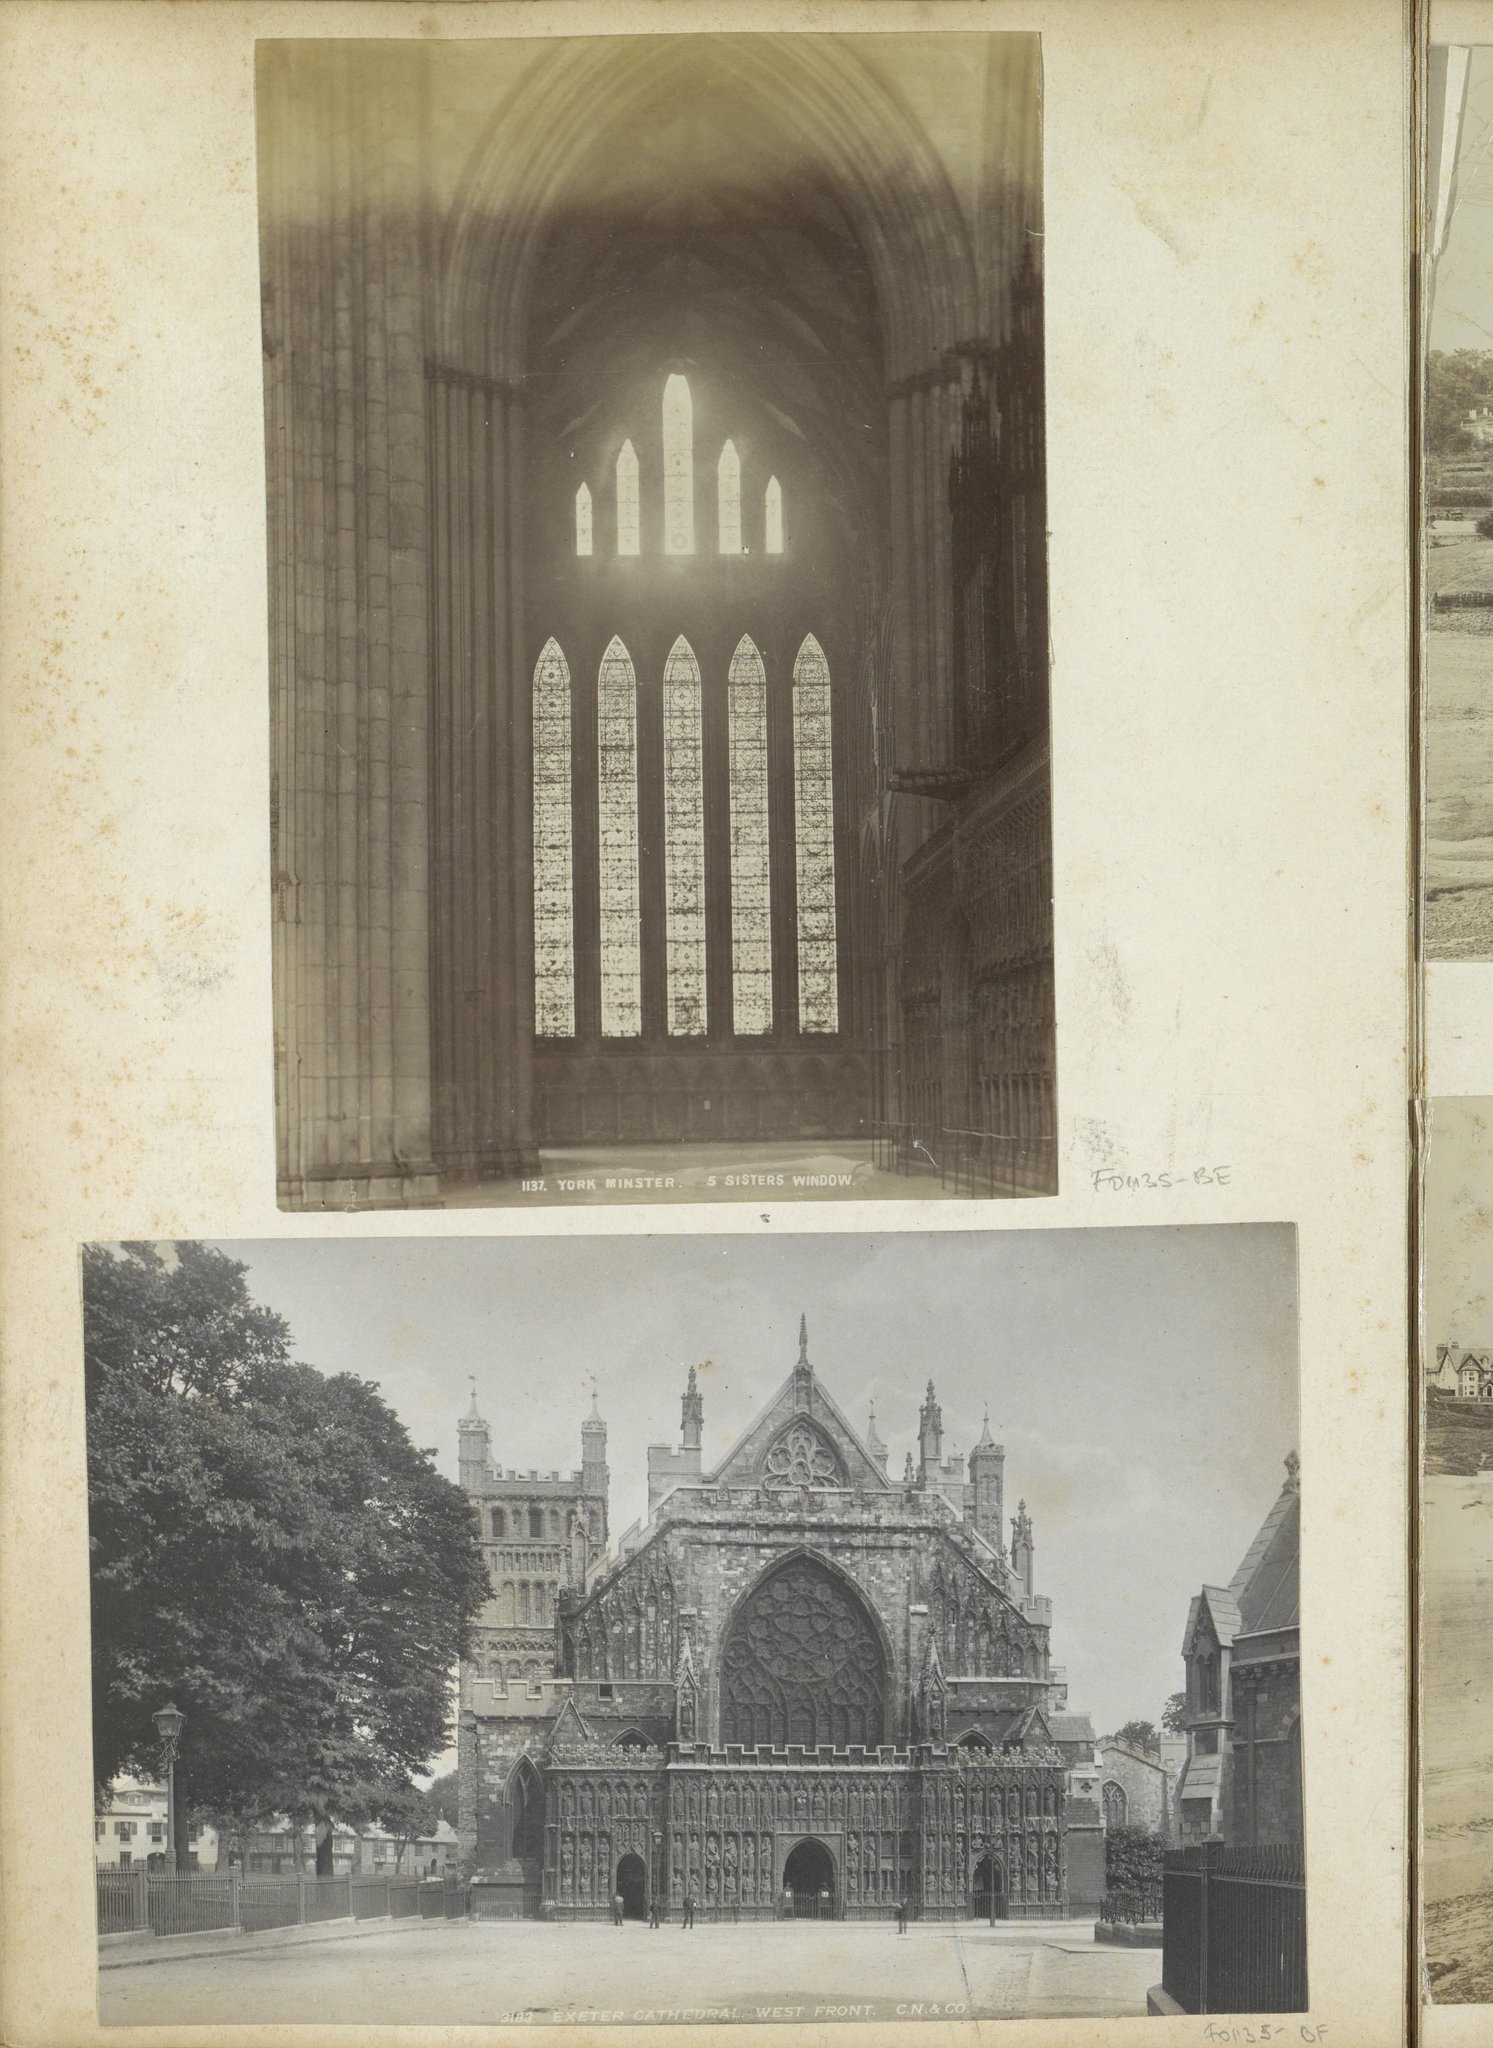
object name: photograph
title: Westzijde van de Kathedraal van Exeter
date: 1899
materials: paper, photographic support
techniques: platinum process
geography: exeter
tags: church (exterior), parts of church exterior and annexes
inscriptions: negative number: ‘3183’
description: Onderdeel van Reisalbum met foto's van bezienswaardigheden in Engeland en Frankrijk.